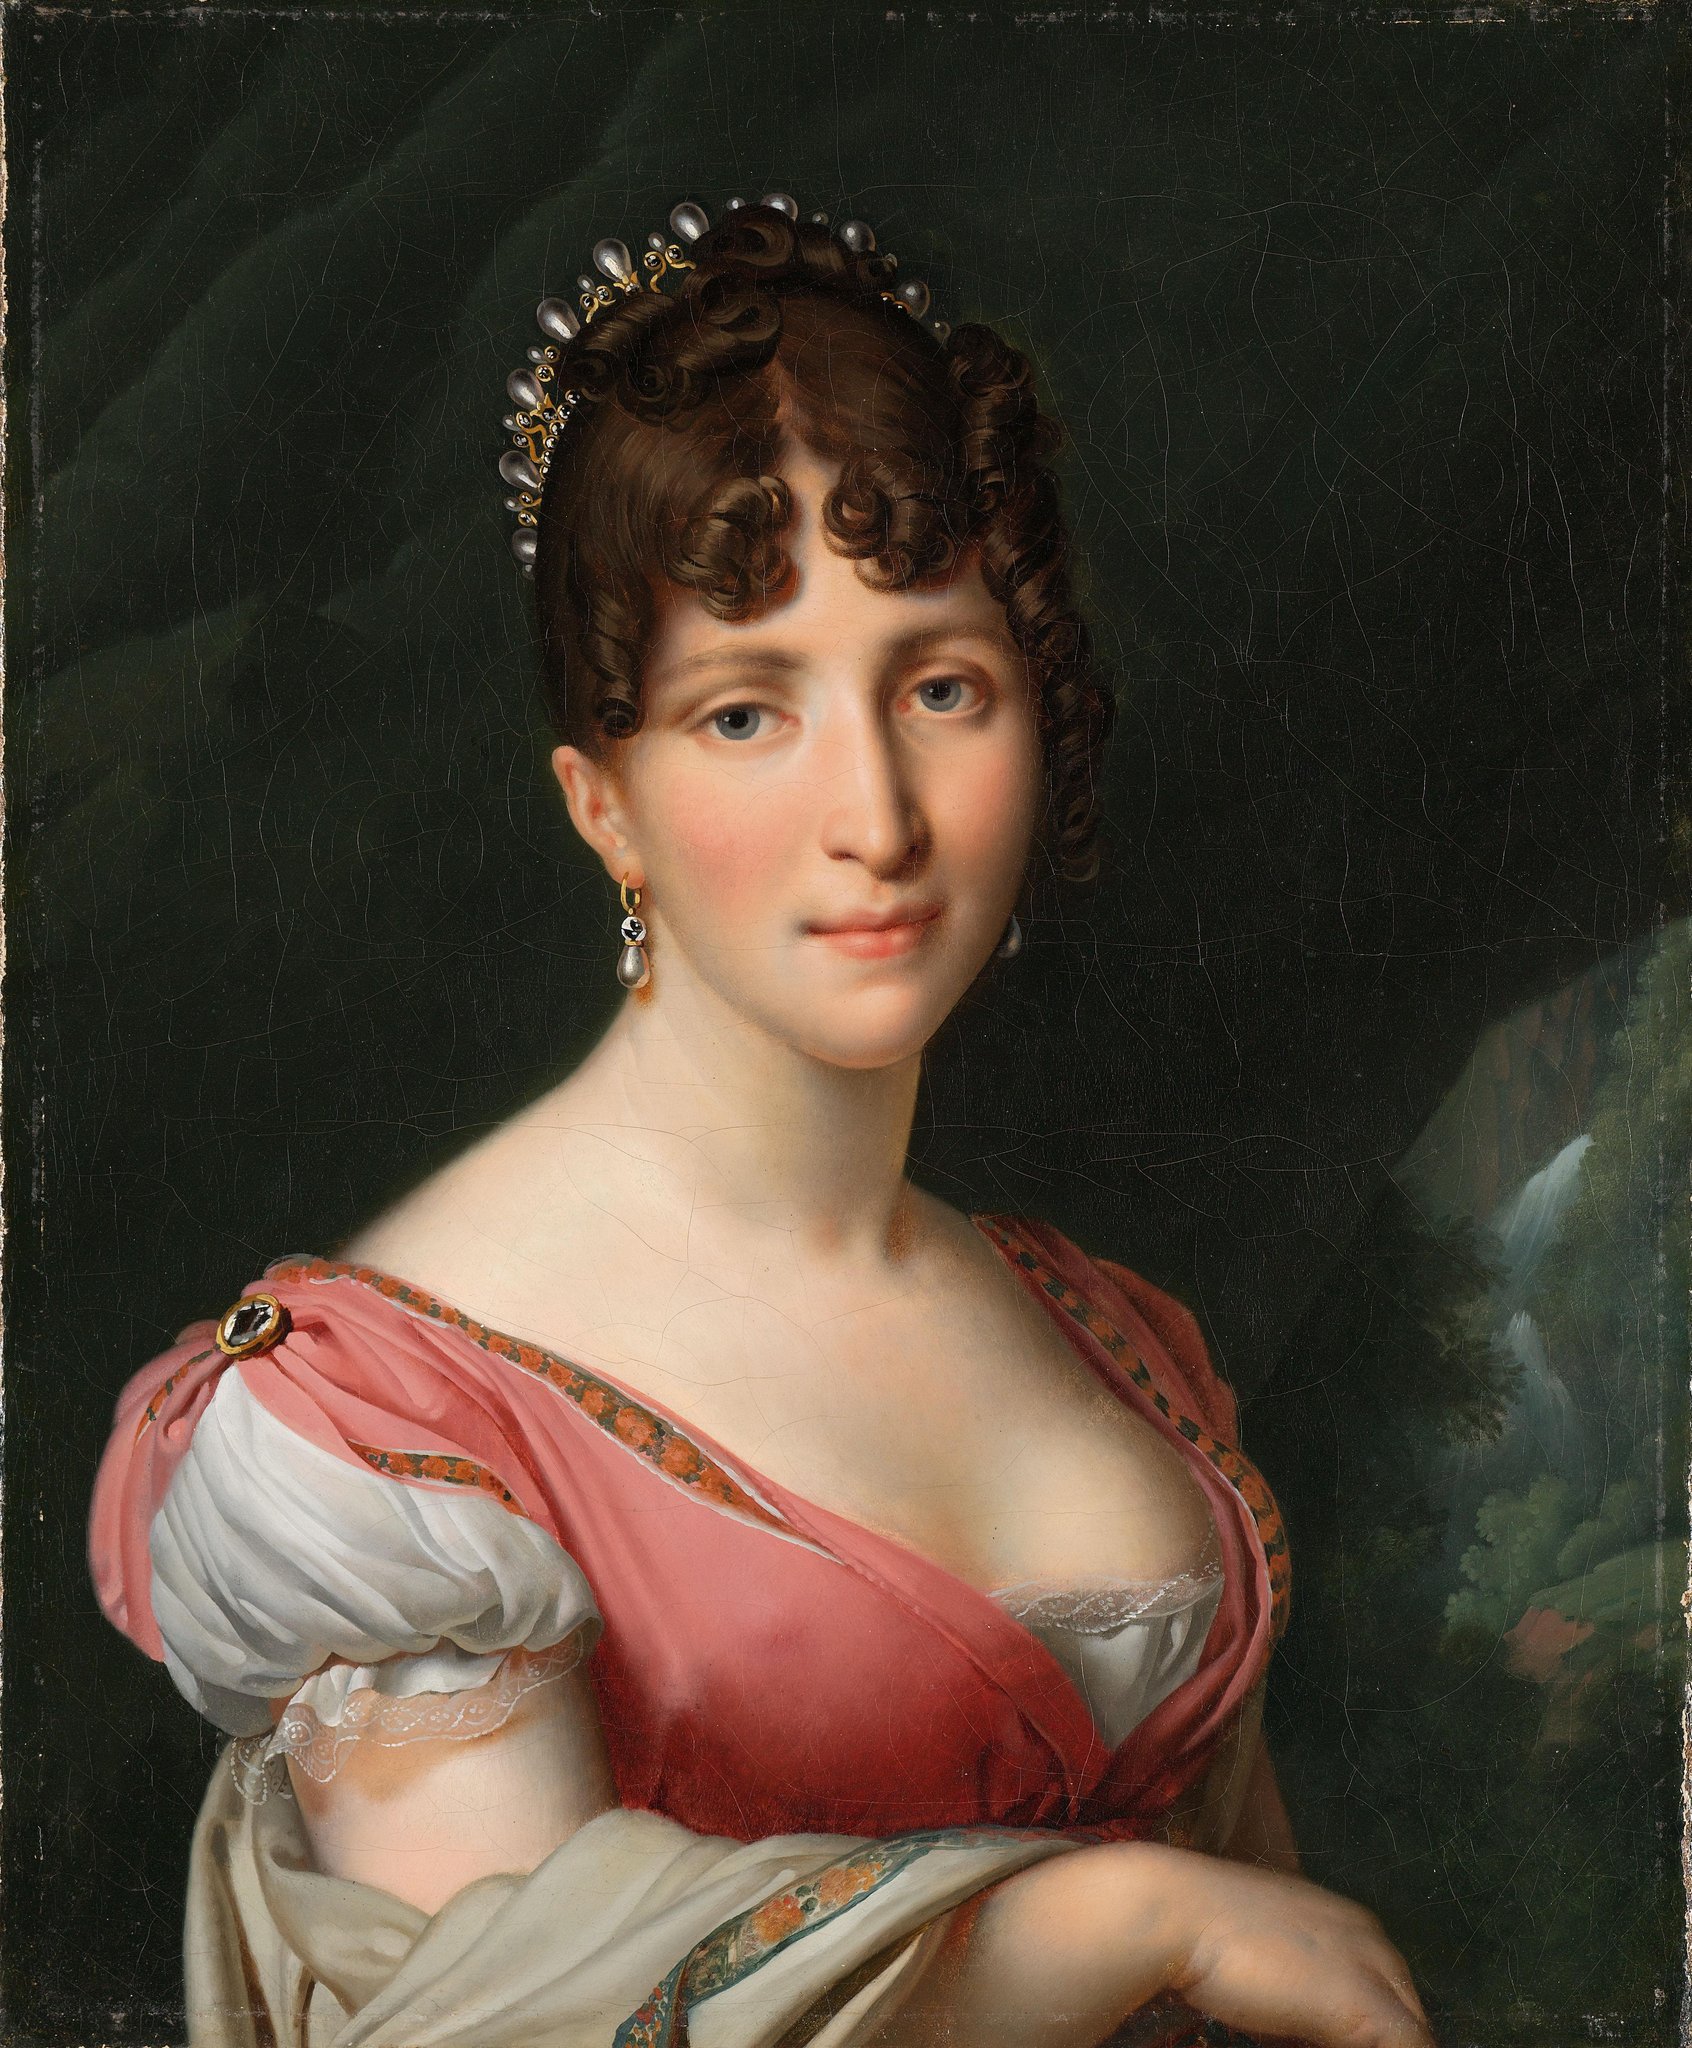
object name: painting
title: Portrait of Hortense de Beauharnais (1783-1837)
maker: anne-louis girodet-trioson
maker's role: draughtsman, painter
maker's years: 1767-1824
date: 1805-1809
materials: canvas, oil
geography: paris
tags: louis napoleon (king of holland), historical persons - bb - woman, queen, empress, etc. (wife of a ruler), holland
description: Hortense de Beauharnais became the first queen of Holland in 1806 when her husband Louis Napoleon ascended the throne. In this portrait, she wears a tiara adorned with pearls, a royal jewel. However, her husband’s reign lasted for only four years, after which De Beauharnais settled on her own in Switzerland. She was a gifted musician and composer, and the cultural gatherings she organized in her home were renowned.